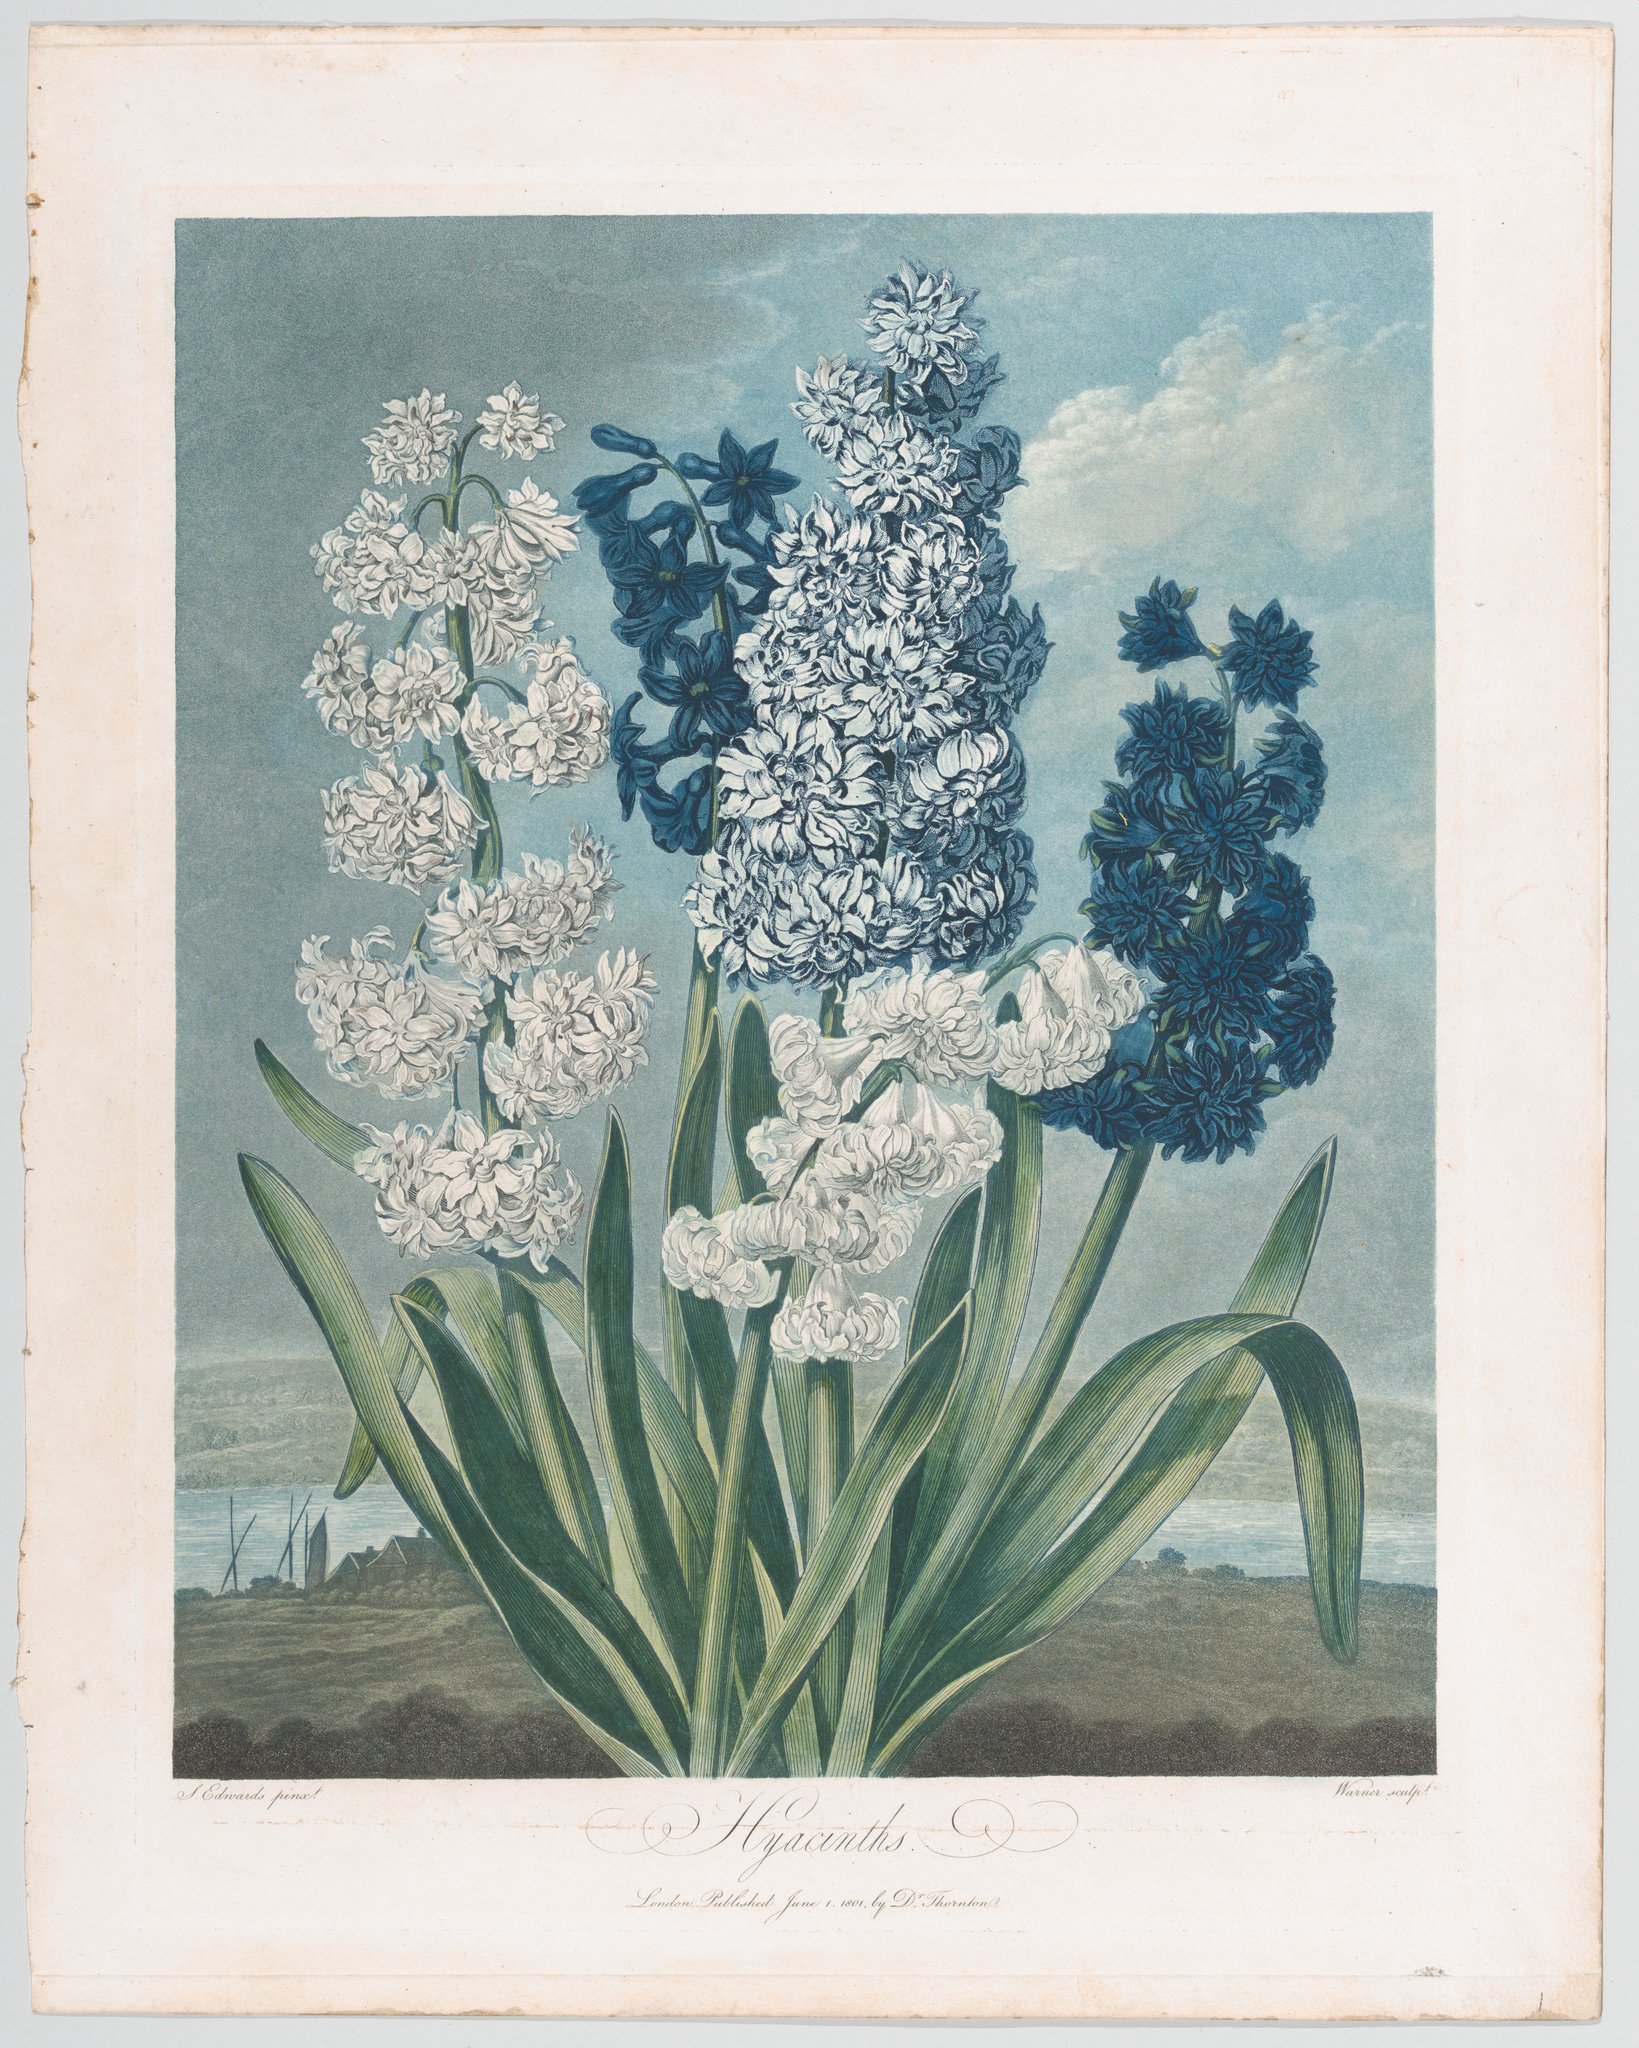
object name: print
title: Hyacinths, from "The Temple of Flora, or Garden of Nature"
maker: thomas warner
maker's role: engraver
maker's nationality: british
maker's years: 1750-1850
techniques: aquatint, hand coloring, printing, engraving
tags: flowers,leaves